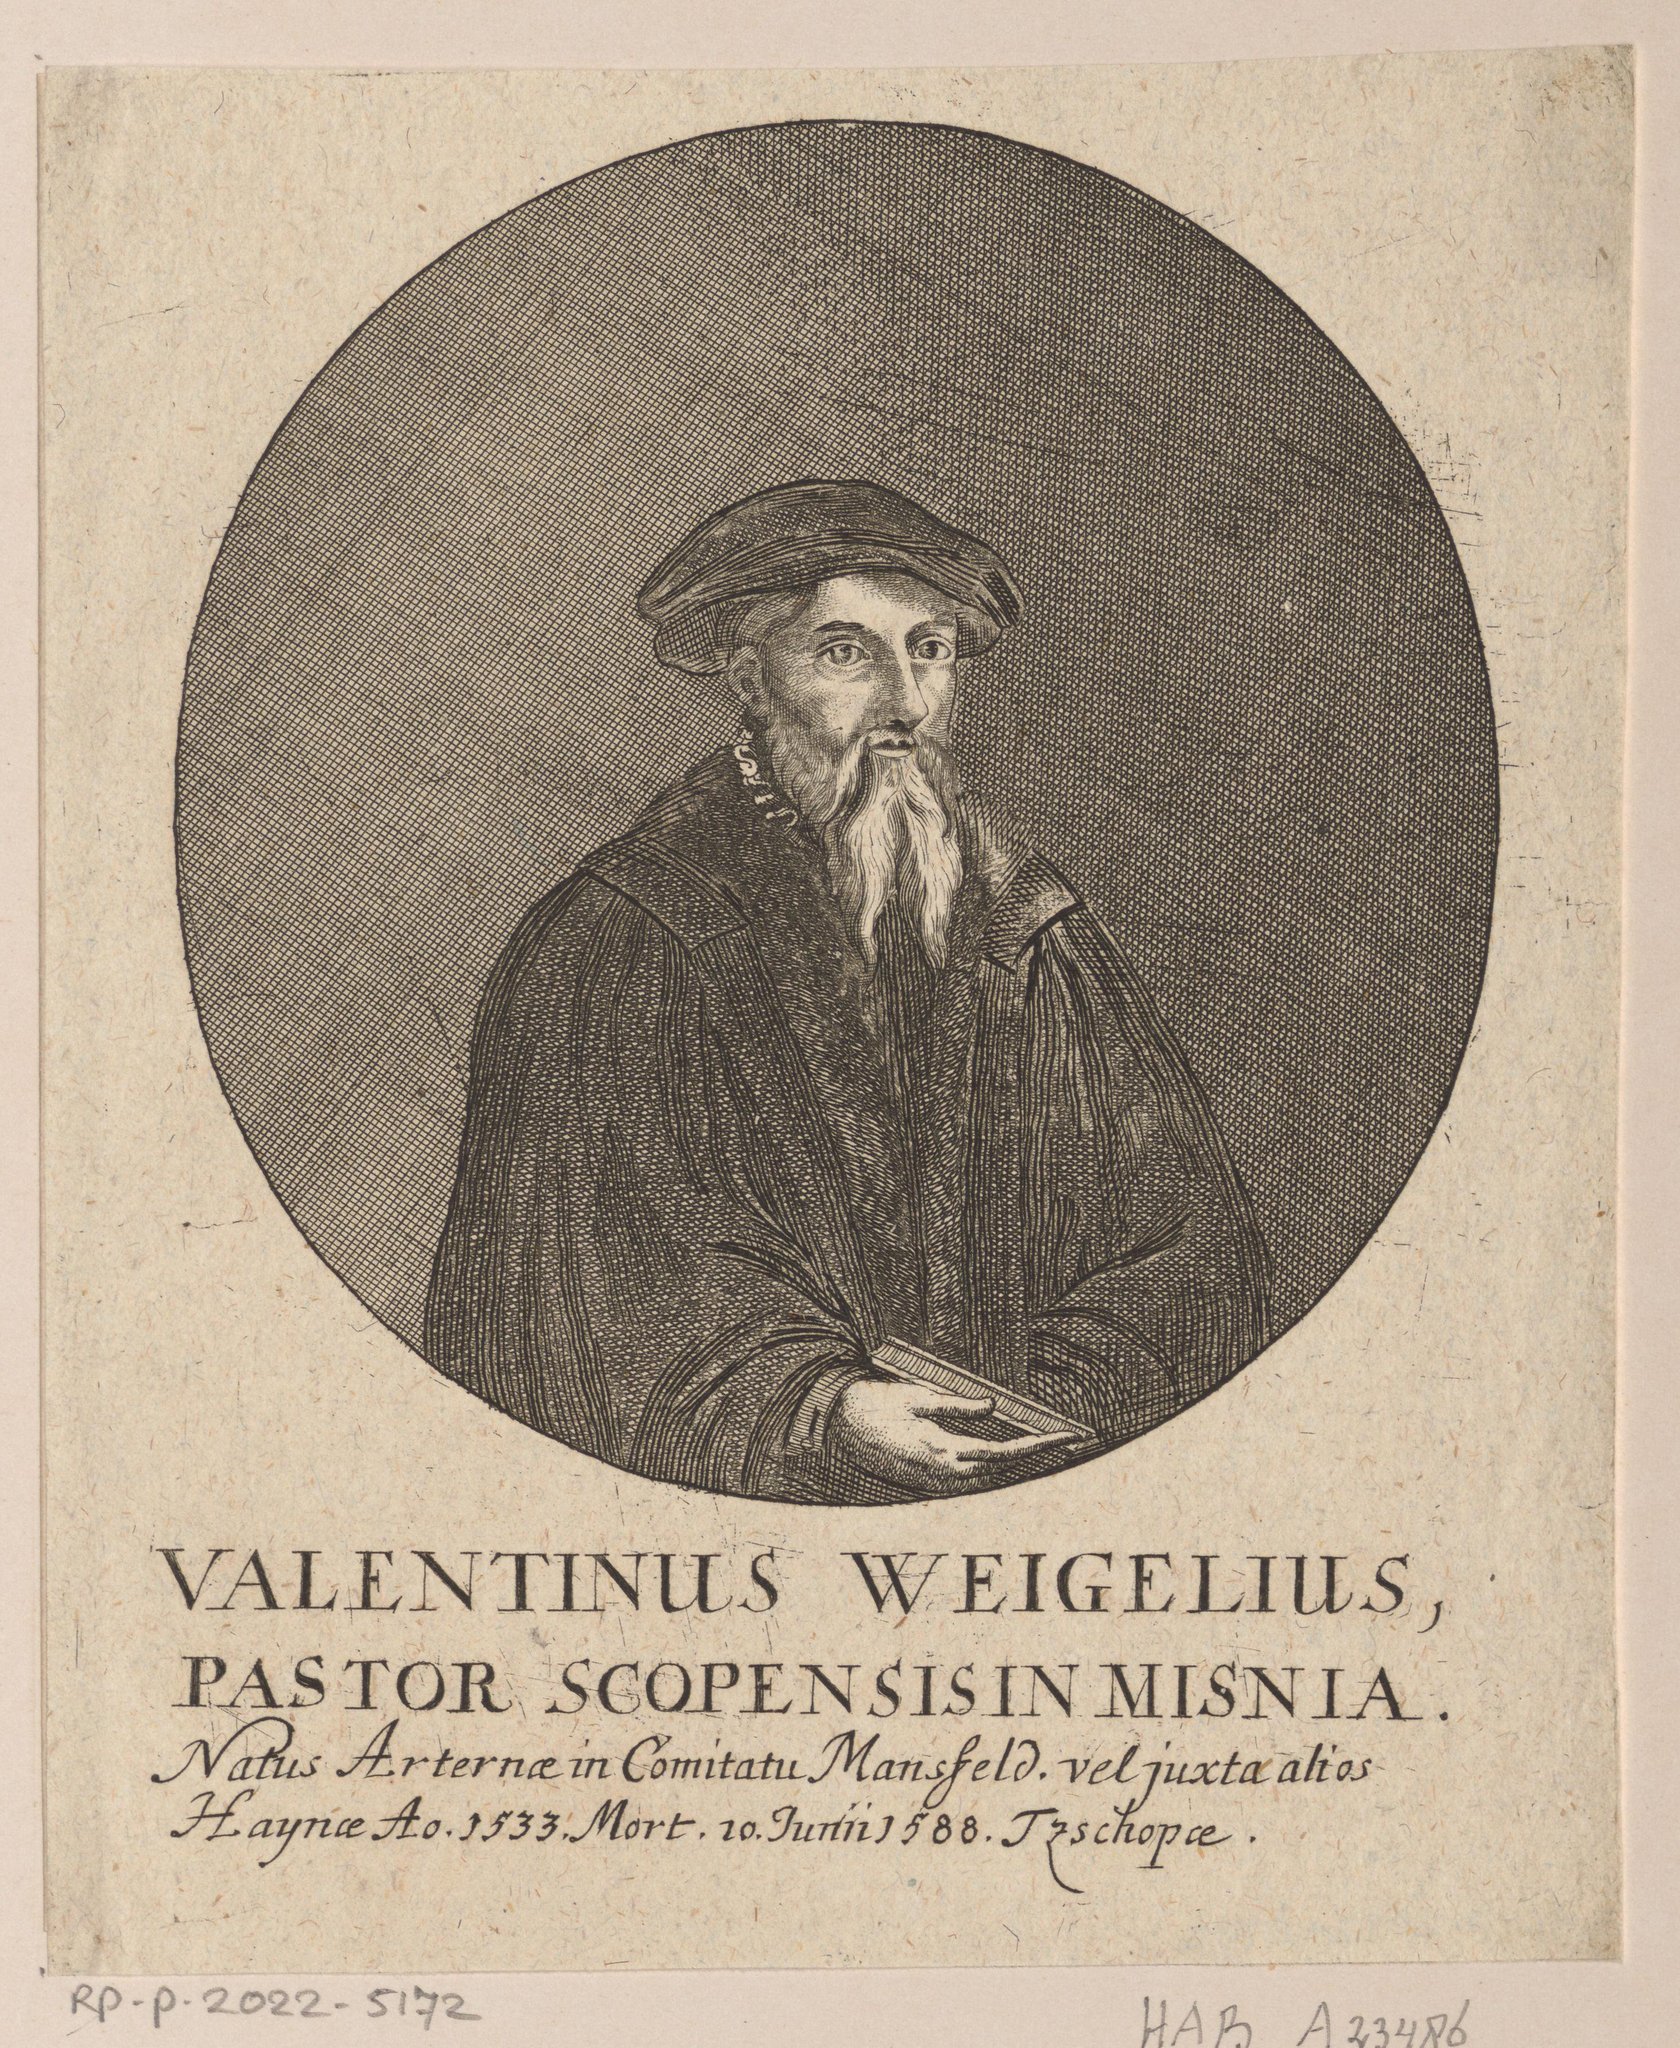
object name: print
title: Portret van Valentin Weigel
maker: Anonymous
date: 1701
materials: paper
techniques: engraving, etching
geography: germany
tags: theologian, historical persons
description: Eerdere staat van prent gebruikt in: Theobald, Zacharias. Der Alten und Neuen Schwärmer, Widertäufferischer Geist (...). Köthen: Wilhelm Andreas Meyer, 1701.